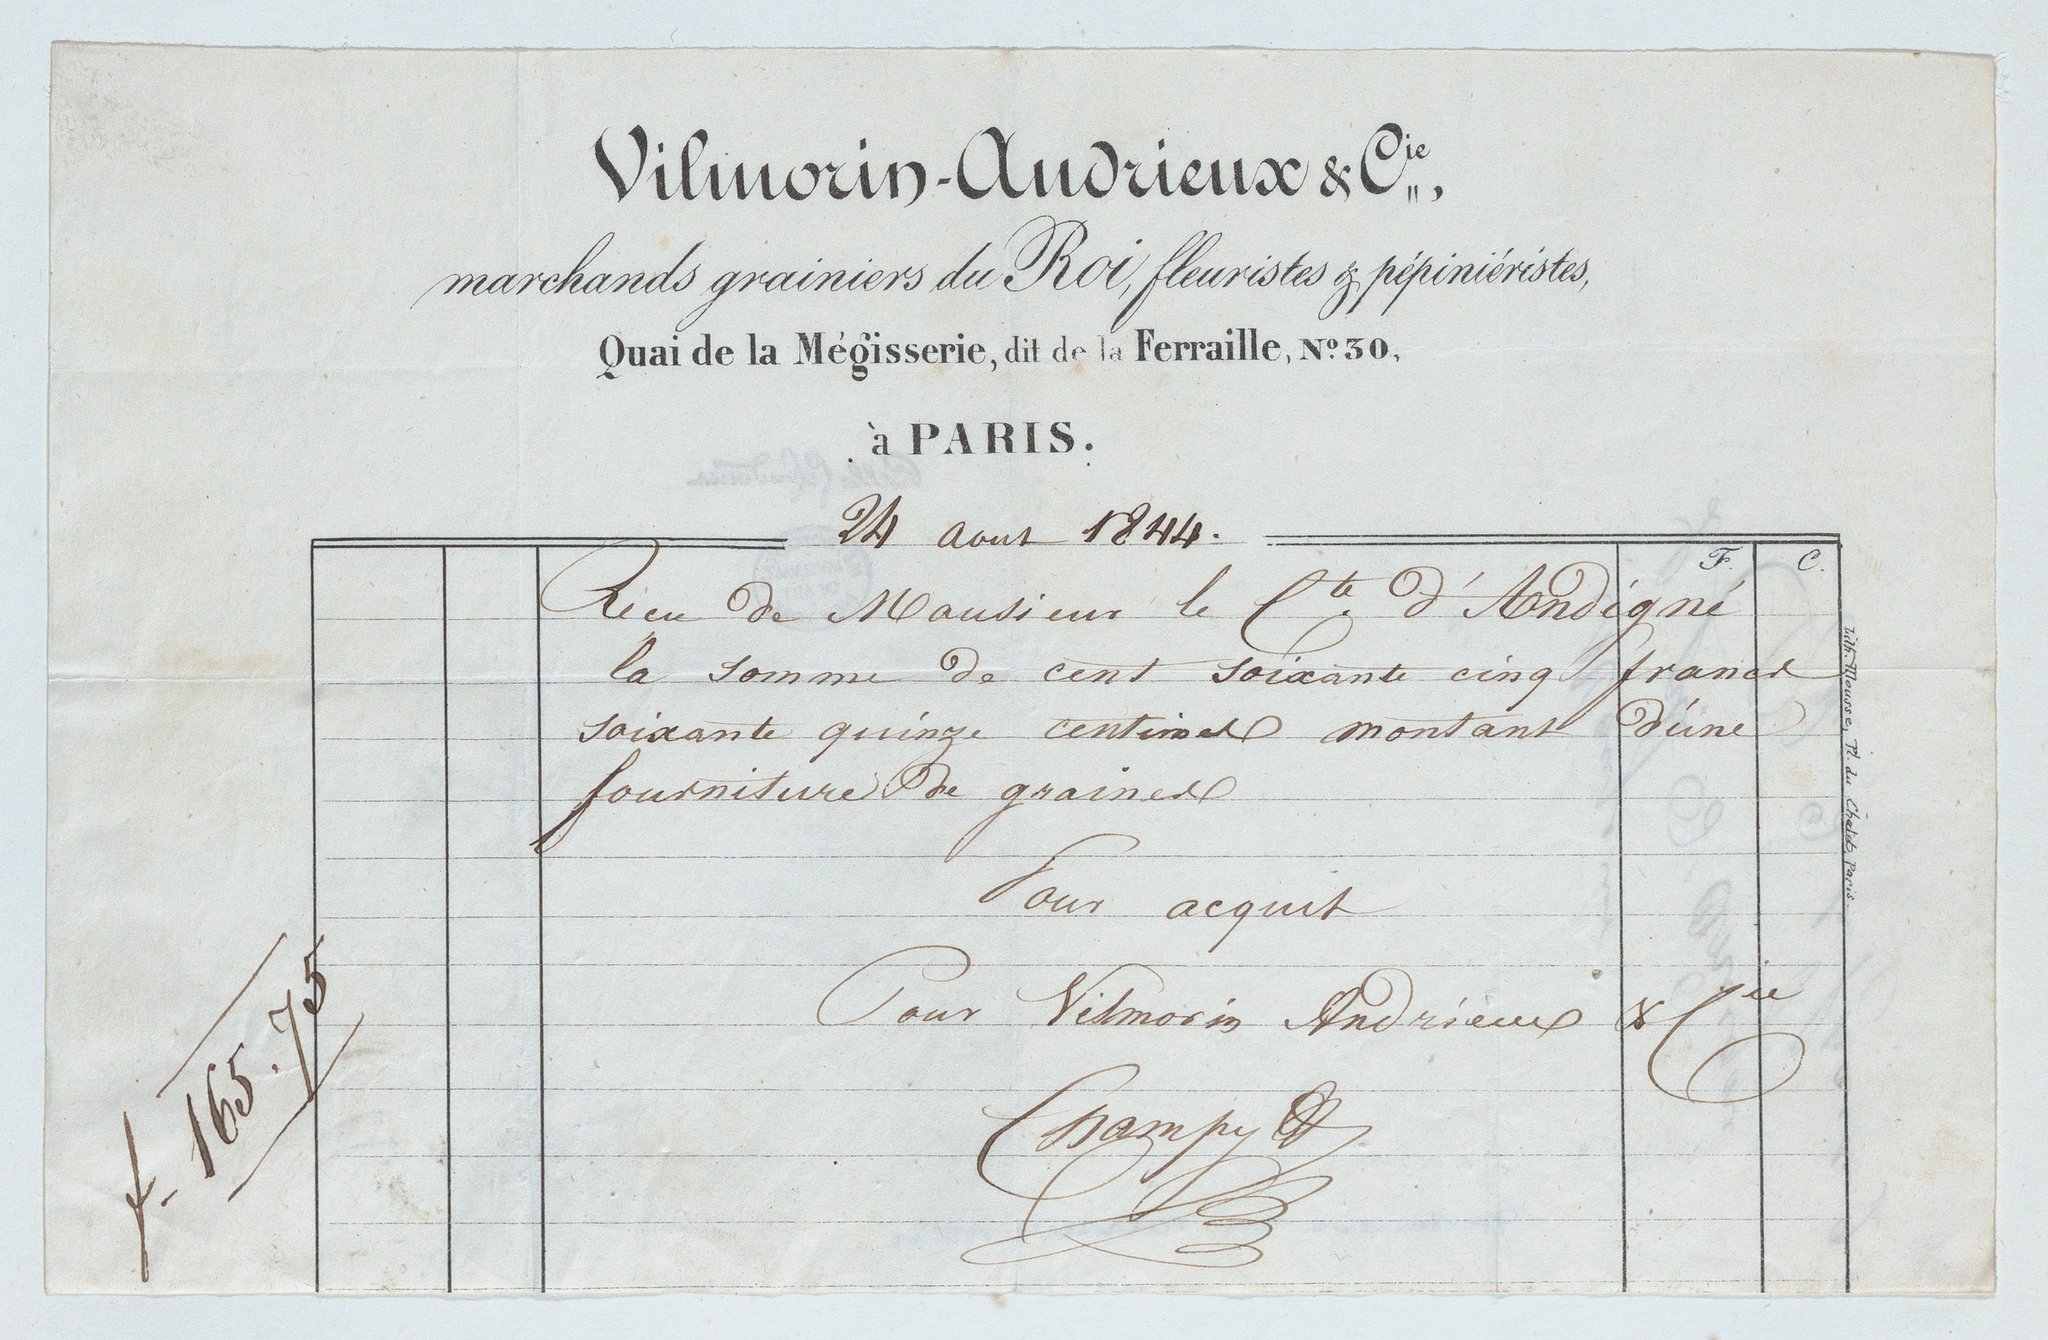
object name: print, ephemera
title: Invoice from Vilmorin-Andrieux et Cie, Paris, for seed supplies to the Count of Andigné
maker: vilmorin andrieux et cie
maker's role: retailer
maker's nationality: french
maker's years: 1743-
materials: ink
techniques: lithograph, pen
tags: documents